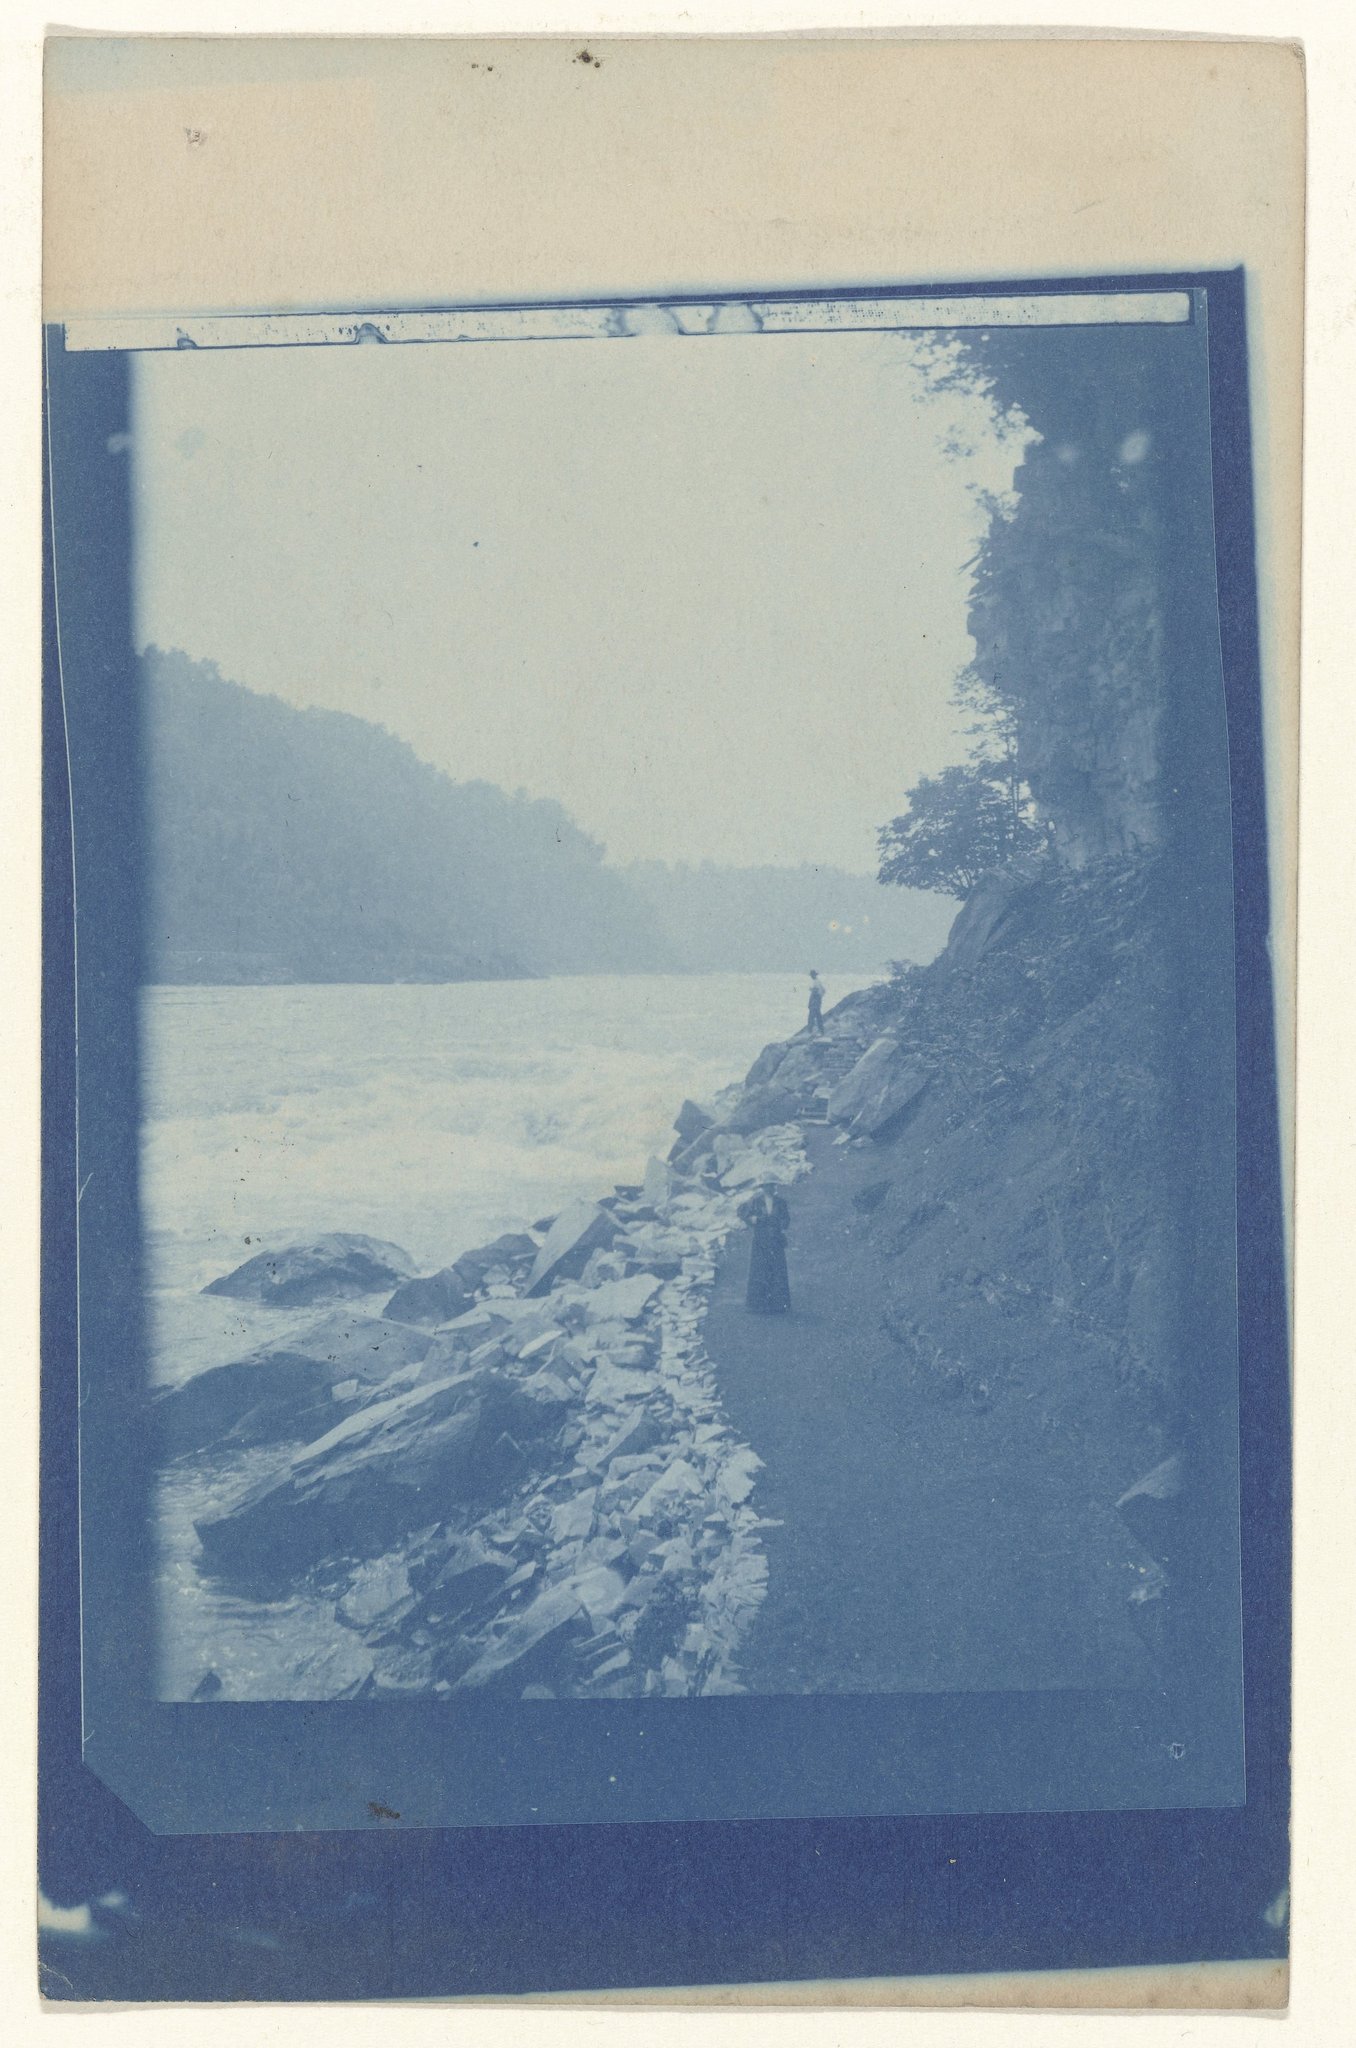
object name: ansichtkaart, prentbriefkaart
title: Vrouw in landschap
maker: Anonymous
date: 1913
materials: paper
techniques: cyanotype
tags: river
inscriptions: inscription: ‘POST CARD // CORRESPONDENCE // ADDRESS ONLY’, stamp: ‘ROCKBRIDGE // MAY / 19 / 1913 // 3 PM // ILL’, inscription: ‘How are you // guess you though[t] // I had forgotten // you. We are well // and busy planting // corn. will finish // 70 acres today. Will be out to see you some of // these days // Bertha(?) // Miss Isabell Wylder // Jerseyville ILL // RR’